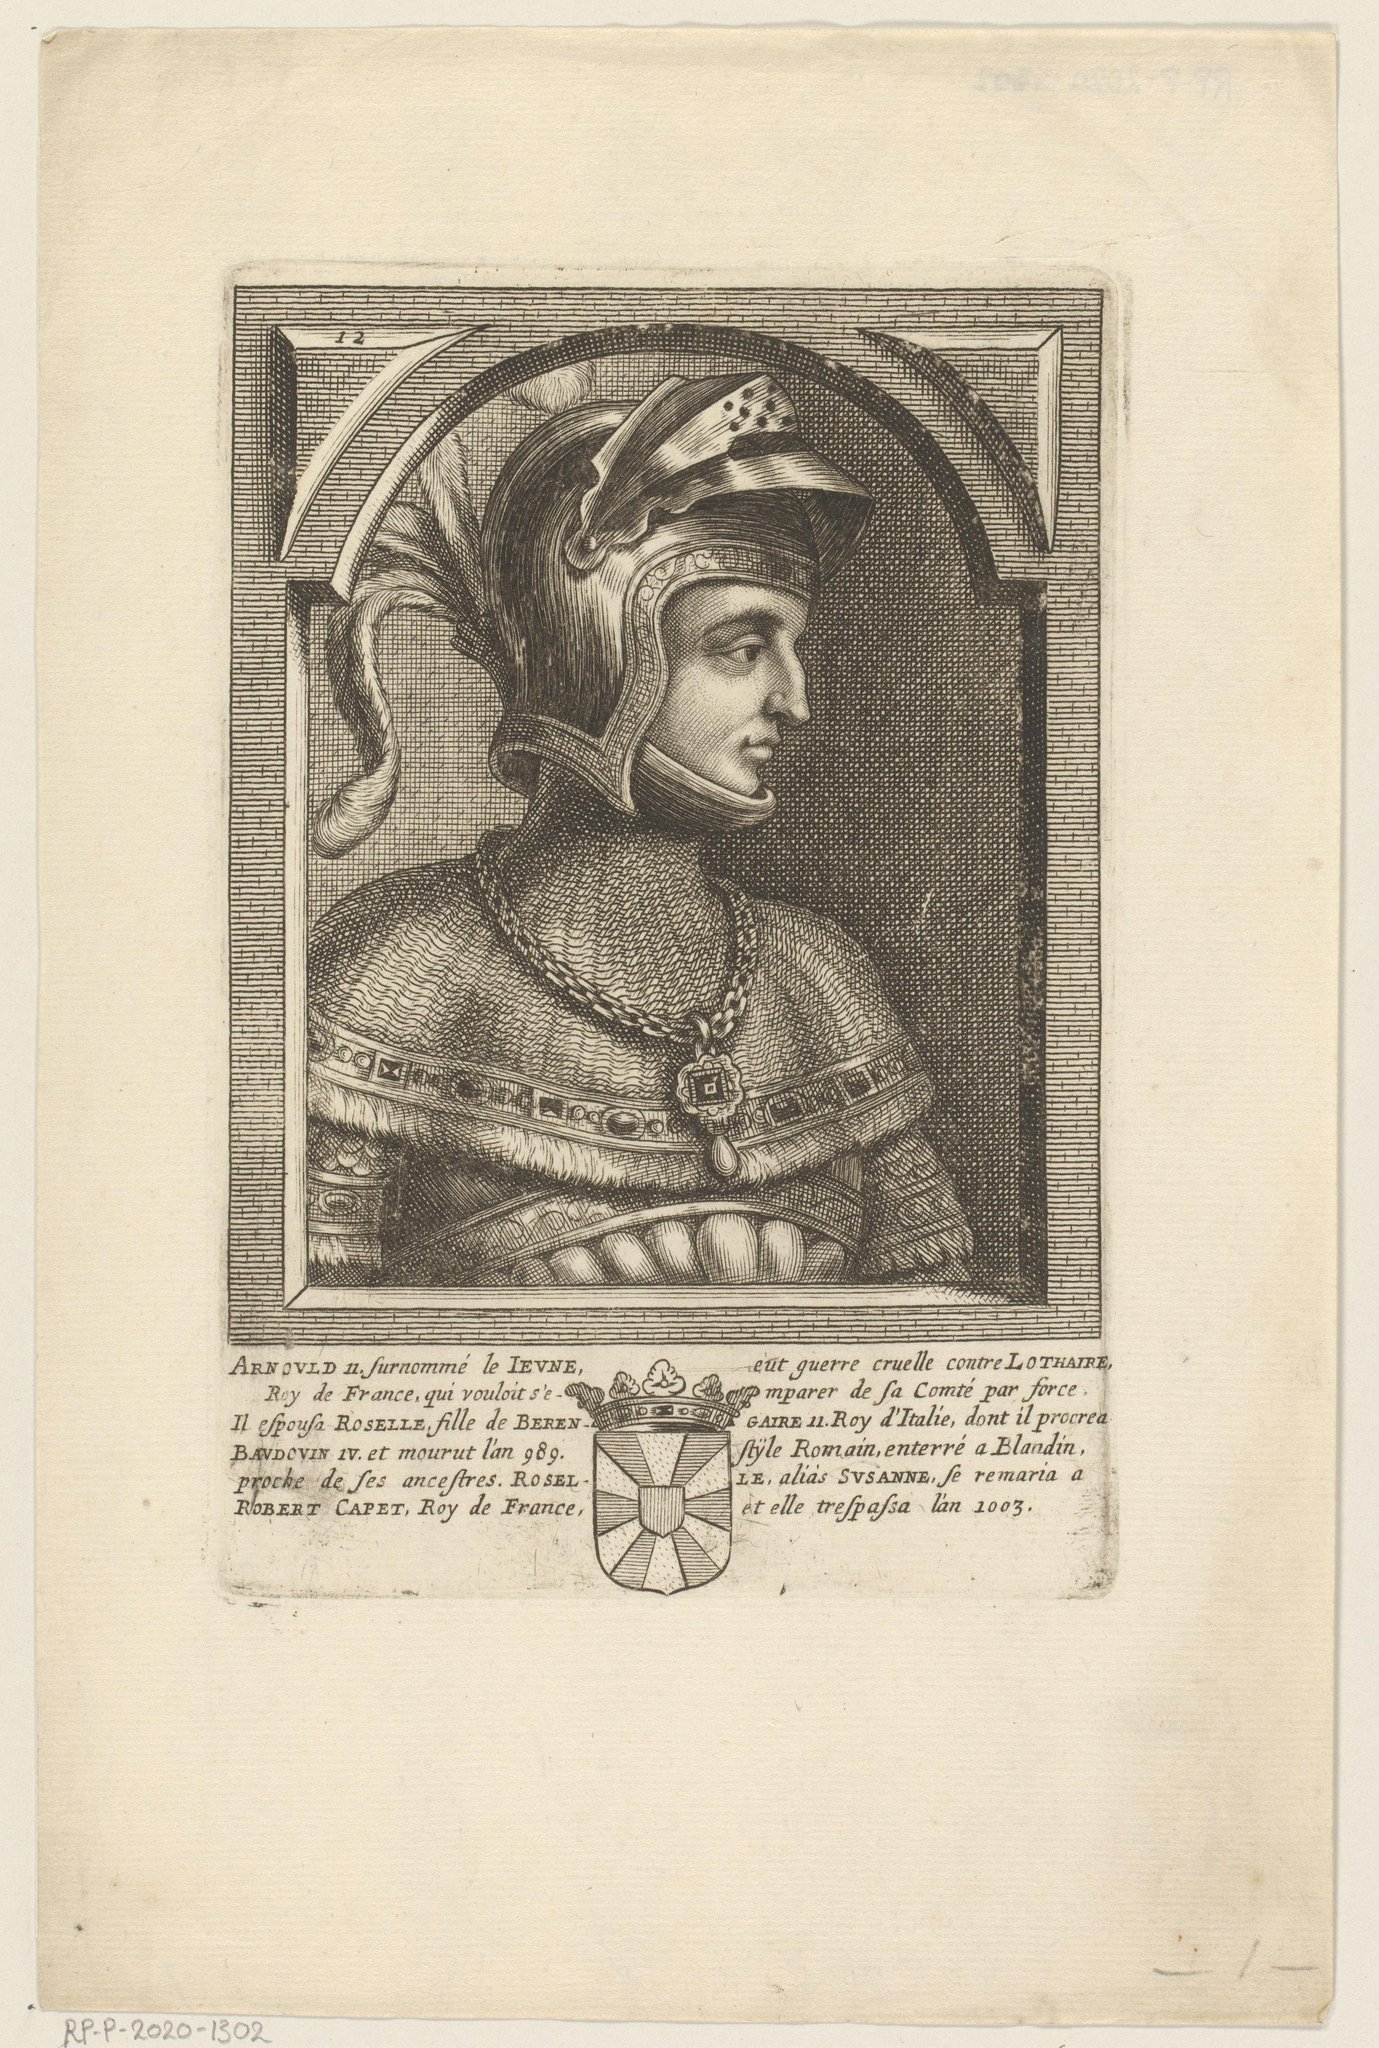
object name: print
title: Portret van Arnulf II, graaf van Vlaanderen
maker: cornelis meyssens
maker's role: print maker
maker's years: 1640-1673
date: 1663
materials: paper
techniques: engraving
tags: earl, historical persons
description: Prent ook gebruikt in: Meyssens, Joannes. Effigies des forestiers et comtes de Flandres. Antwerpen: Joannes Meyssens, 1663.